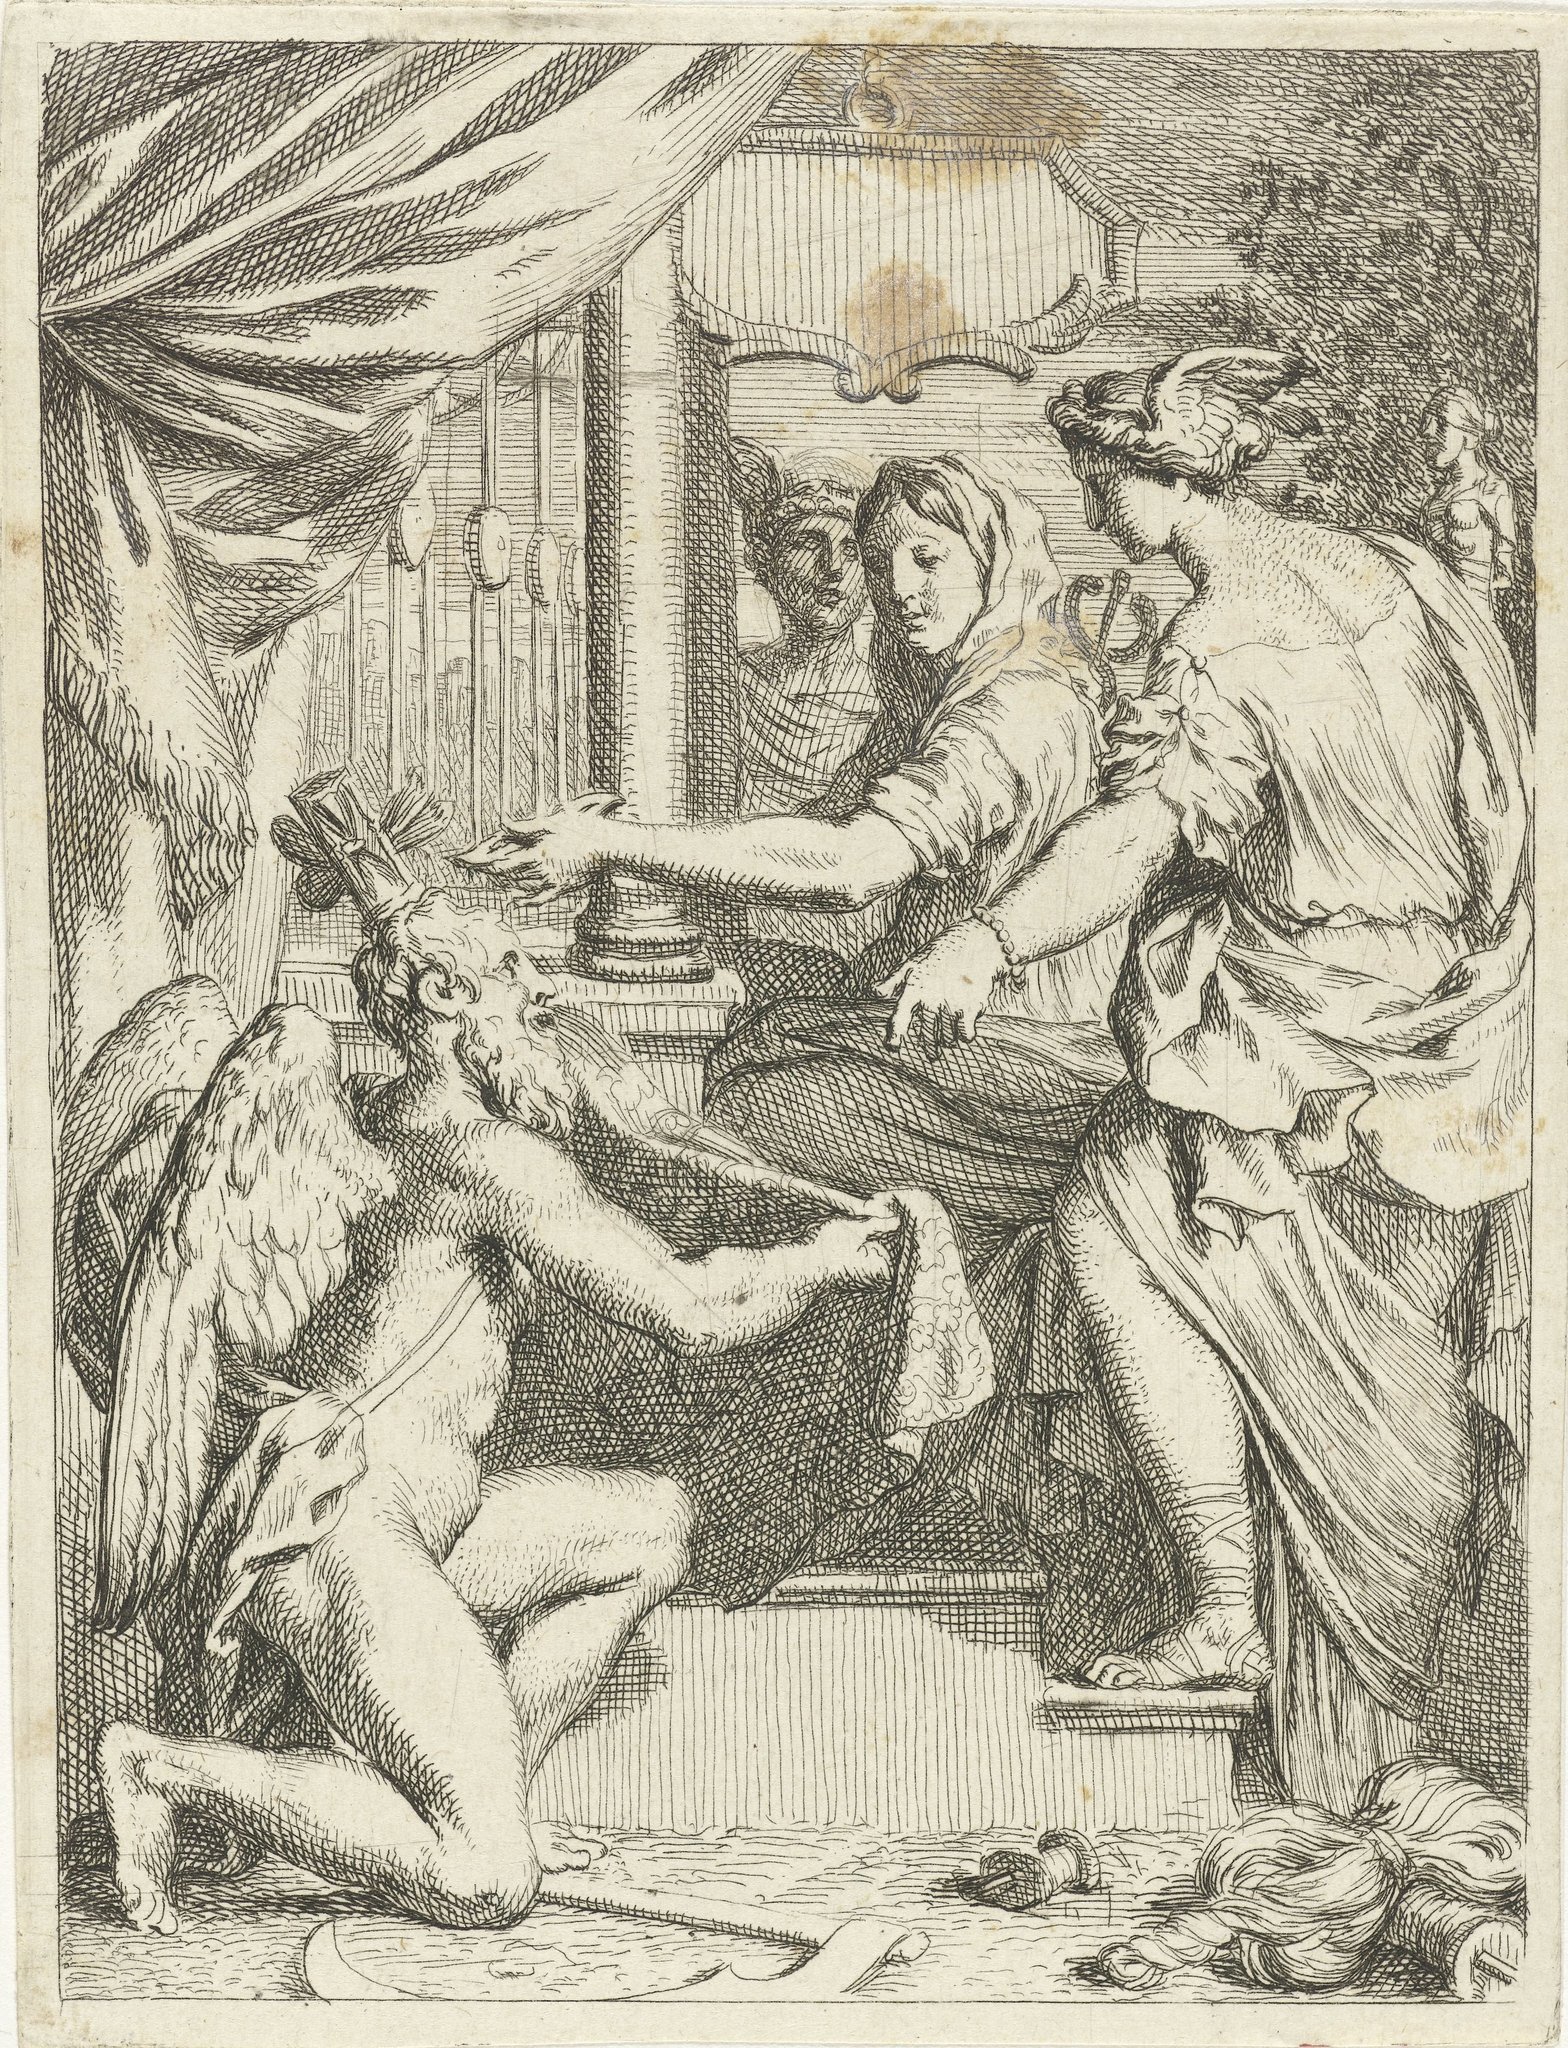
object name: print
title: De Tijd knielt voor een handwerkster bij een weefgetouw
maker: gerard de lairesse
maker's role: draughtsman, painter, print maker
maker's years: 1641-1711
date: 1675-1680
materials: paper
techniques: etching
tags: invention, inventiveness; 'inventione' (ripa), (story of) mercury (hermes), weaving-loom, father time, man with wings and scythe, textile fabric, cloth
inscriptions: collector's mark: Lugt 240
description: De gevleugelde Tijd is met een stuk stof in zijn handen, symbool van kwaliteit en duurzaamheid, neergeknield voor een vrouw die aan het werk is achter een weefgetouw. De handwerkster wordt rechts bijgestaan door Mercurius, god van de handel. Op de achtergrond kijkt de gepersonifieerde inventie toe.